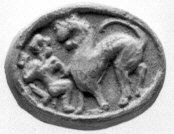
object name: stamp seal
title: Conoid seal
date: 1200-801 BCE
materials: stone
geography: cyprus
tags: animals